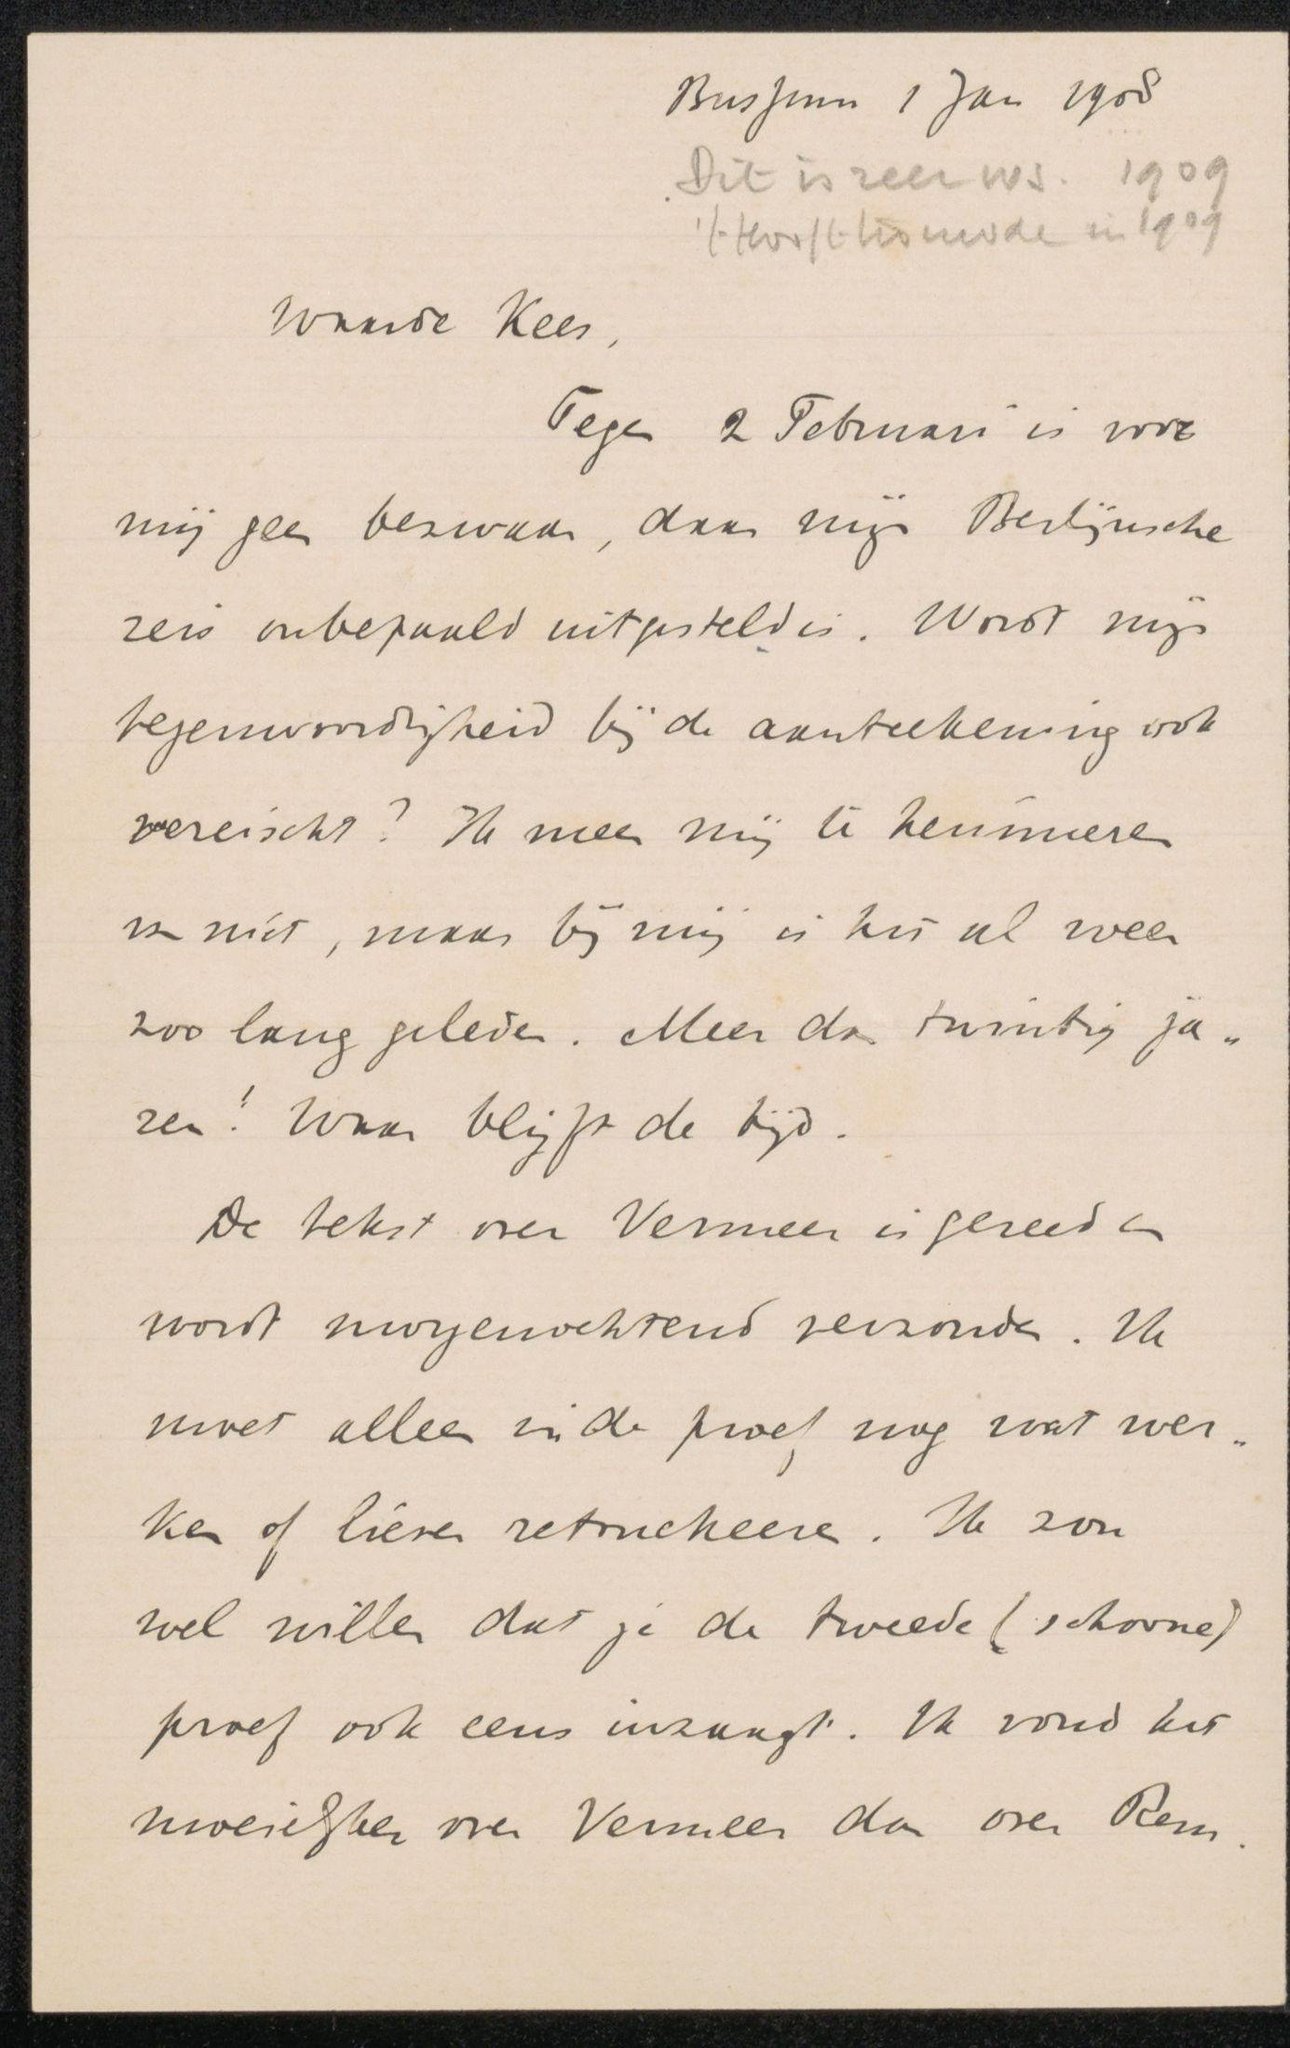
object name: letter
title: Brief aan Cornelis Gerardus 't Hooft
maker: jan veth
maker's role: designer, draughtsman, painter, print maker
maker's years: 1864-1925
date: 1909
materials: ink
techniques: pen, writing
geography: bussum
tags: delft, painter, draughtsman, johannes vermeer, leiden, rembrandt van rijn, dordrecht, cornelis gerardus 't hooft, family life, travelling; tourism, printed matter, berlin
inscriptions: watermark, collector's mark: ‘RPK’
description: Brief is door schrijver waarschijnlijk foutief gedateerd 1 januari 1908, want Cornelis Gerardus 't Hooft trouwde in 1909. Zie ook brief RP-D-1984-C.G.THOOFT-30.